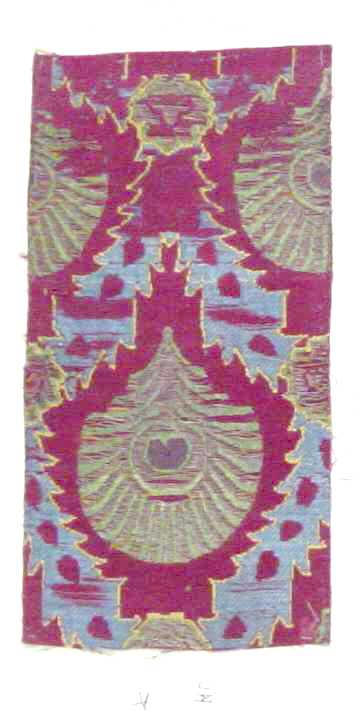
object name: textile fragment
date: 1601-1633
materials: metal thread, silk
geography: turkey